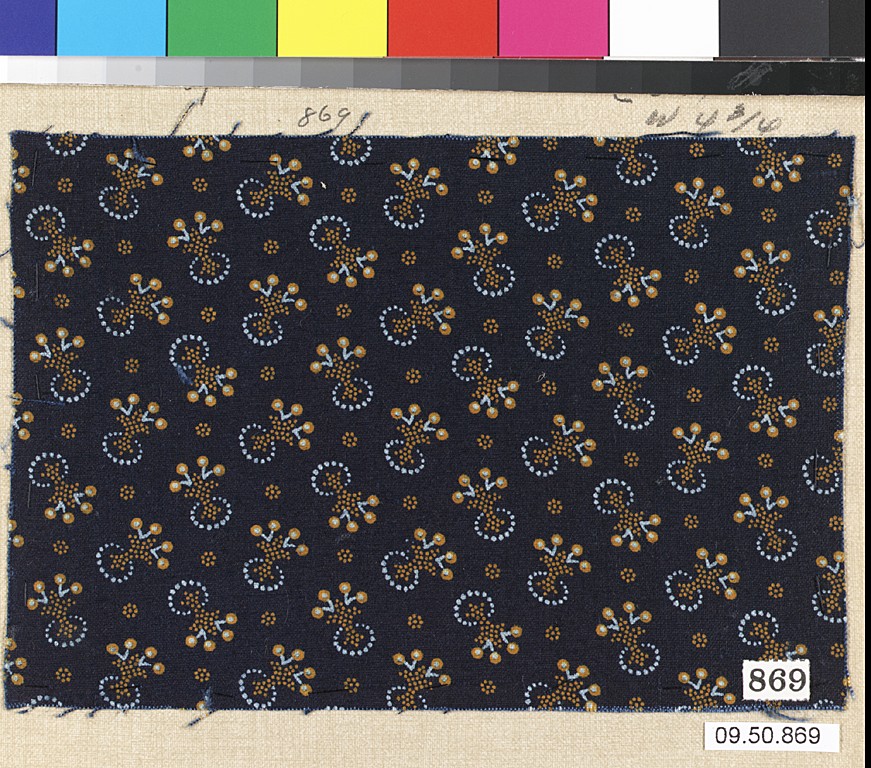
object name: piece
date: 1801-1900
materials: cotton